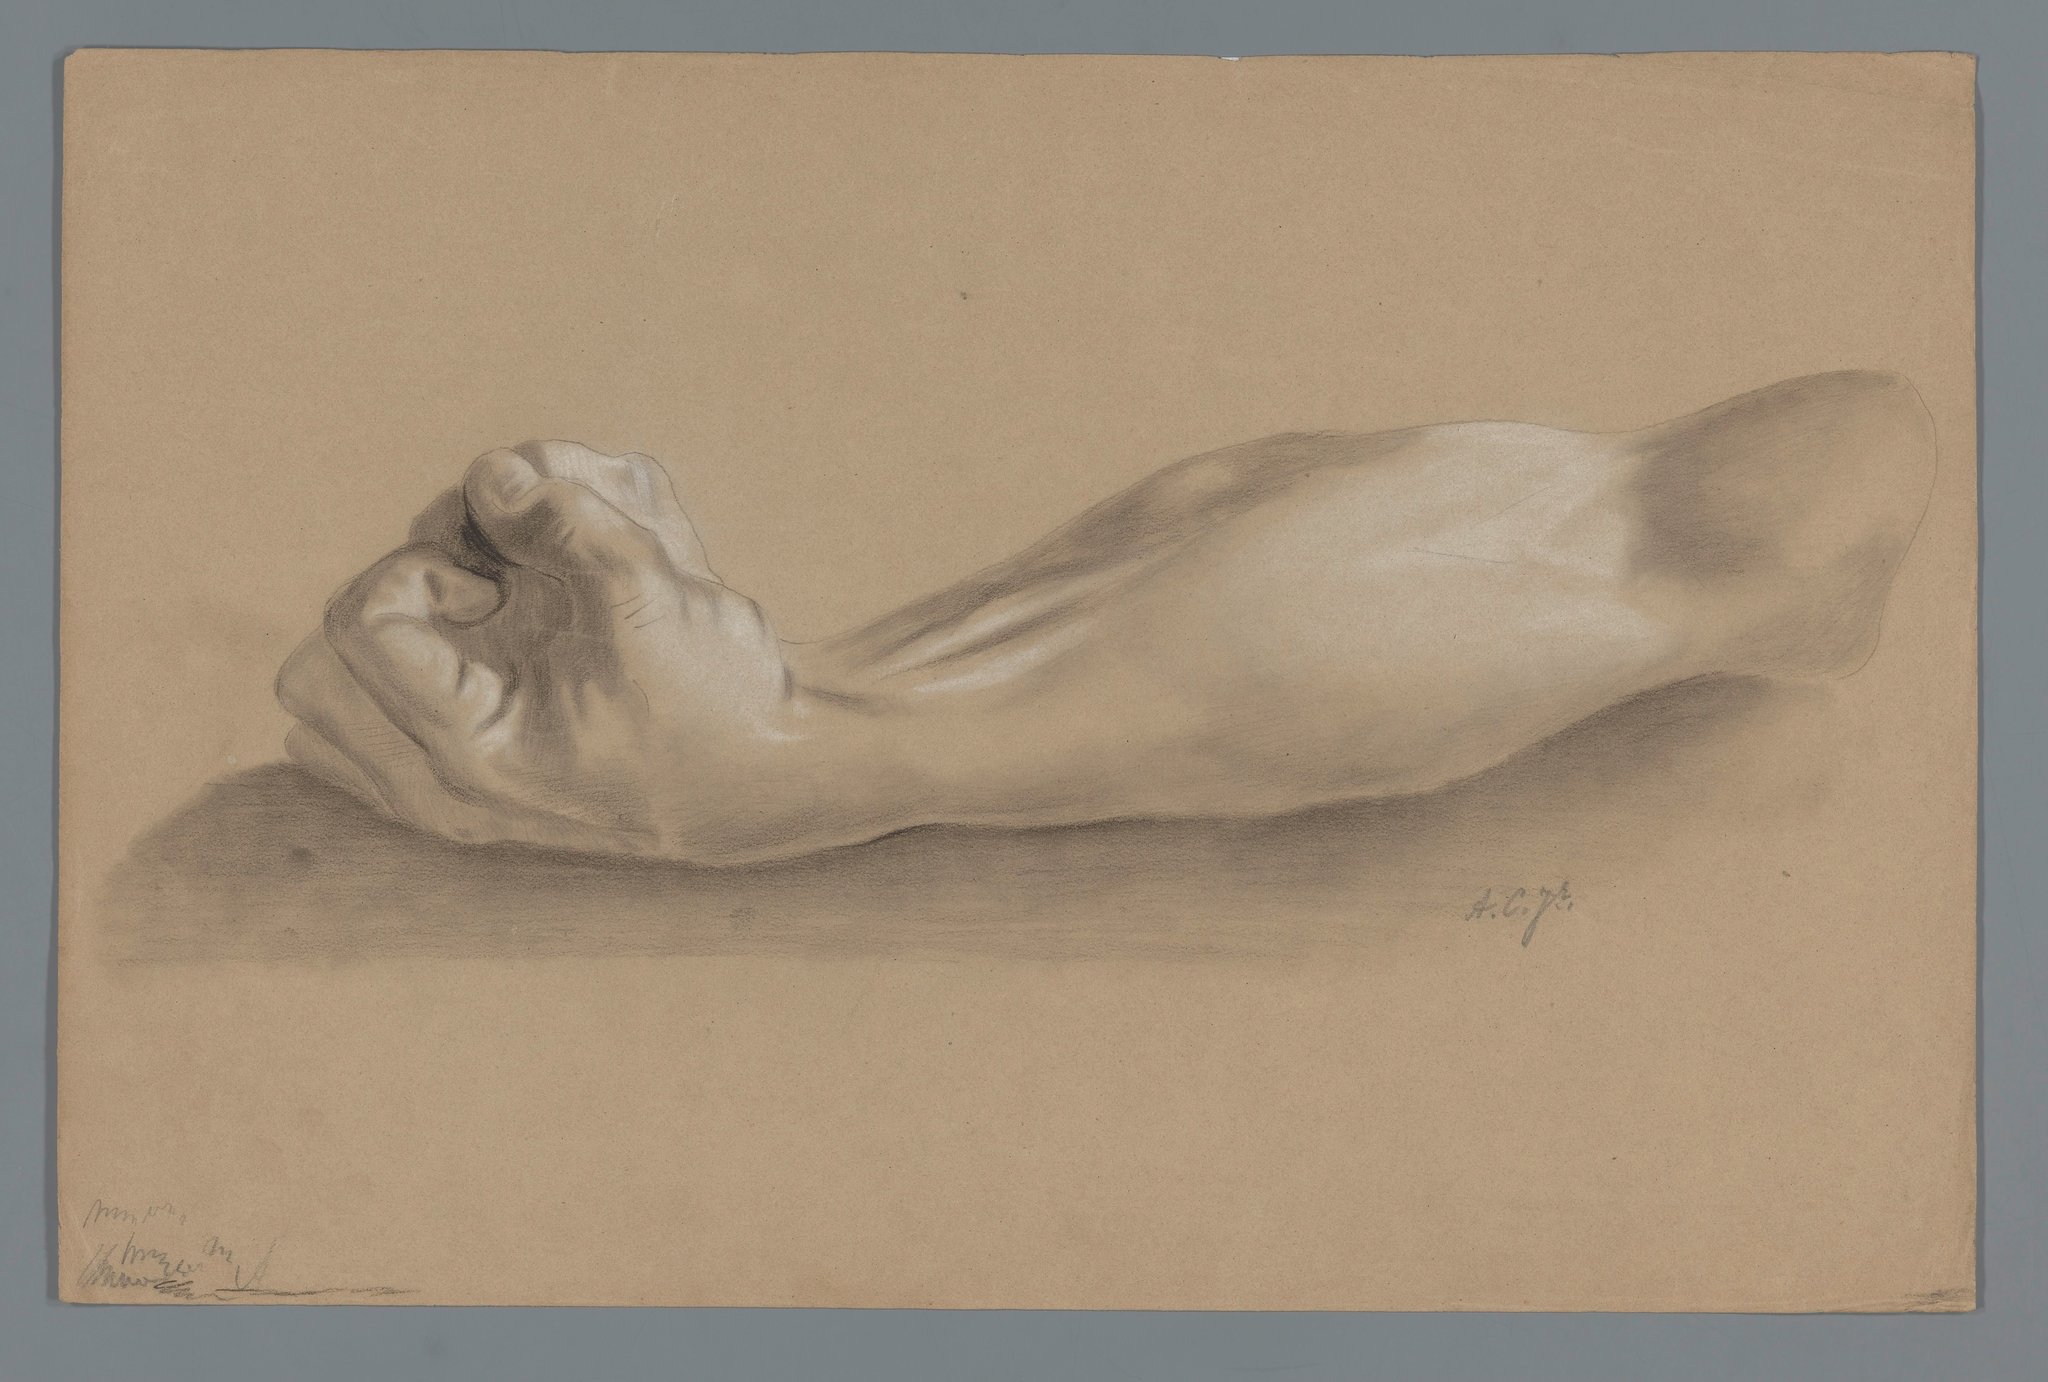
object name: drawing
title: Gipsmodel van een arm met gebalde vuist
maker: alexander cranendoncq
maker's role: draughtsman, print maker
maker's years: 1799-1869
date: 1800-1900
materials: chalk, paper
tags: piece of sculpture, reproduction of a piece of sculpture (+ reproduction ~ work of art), arms